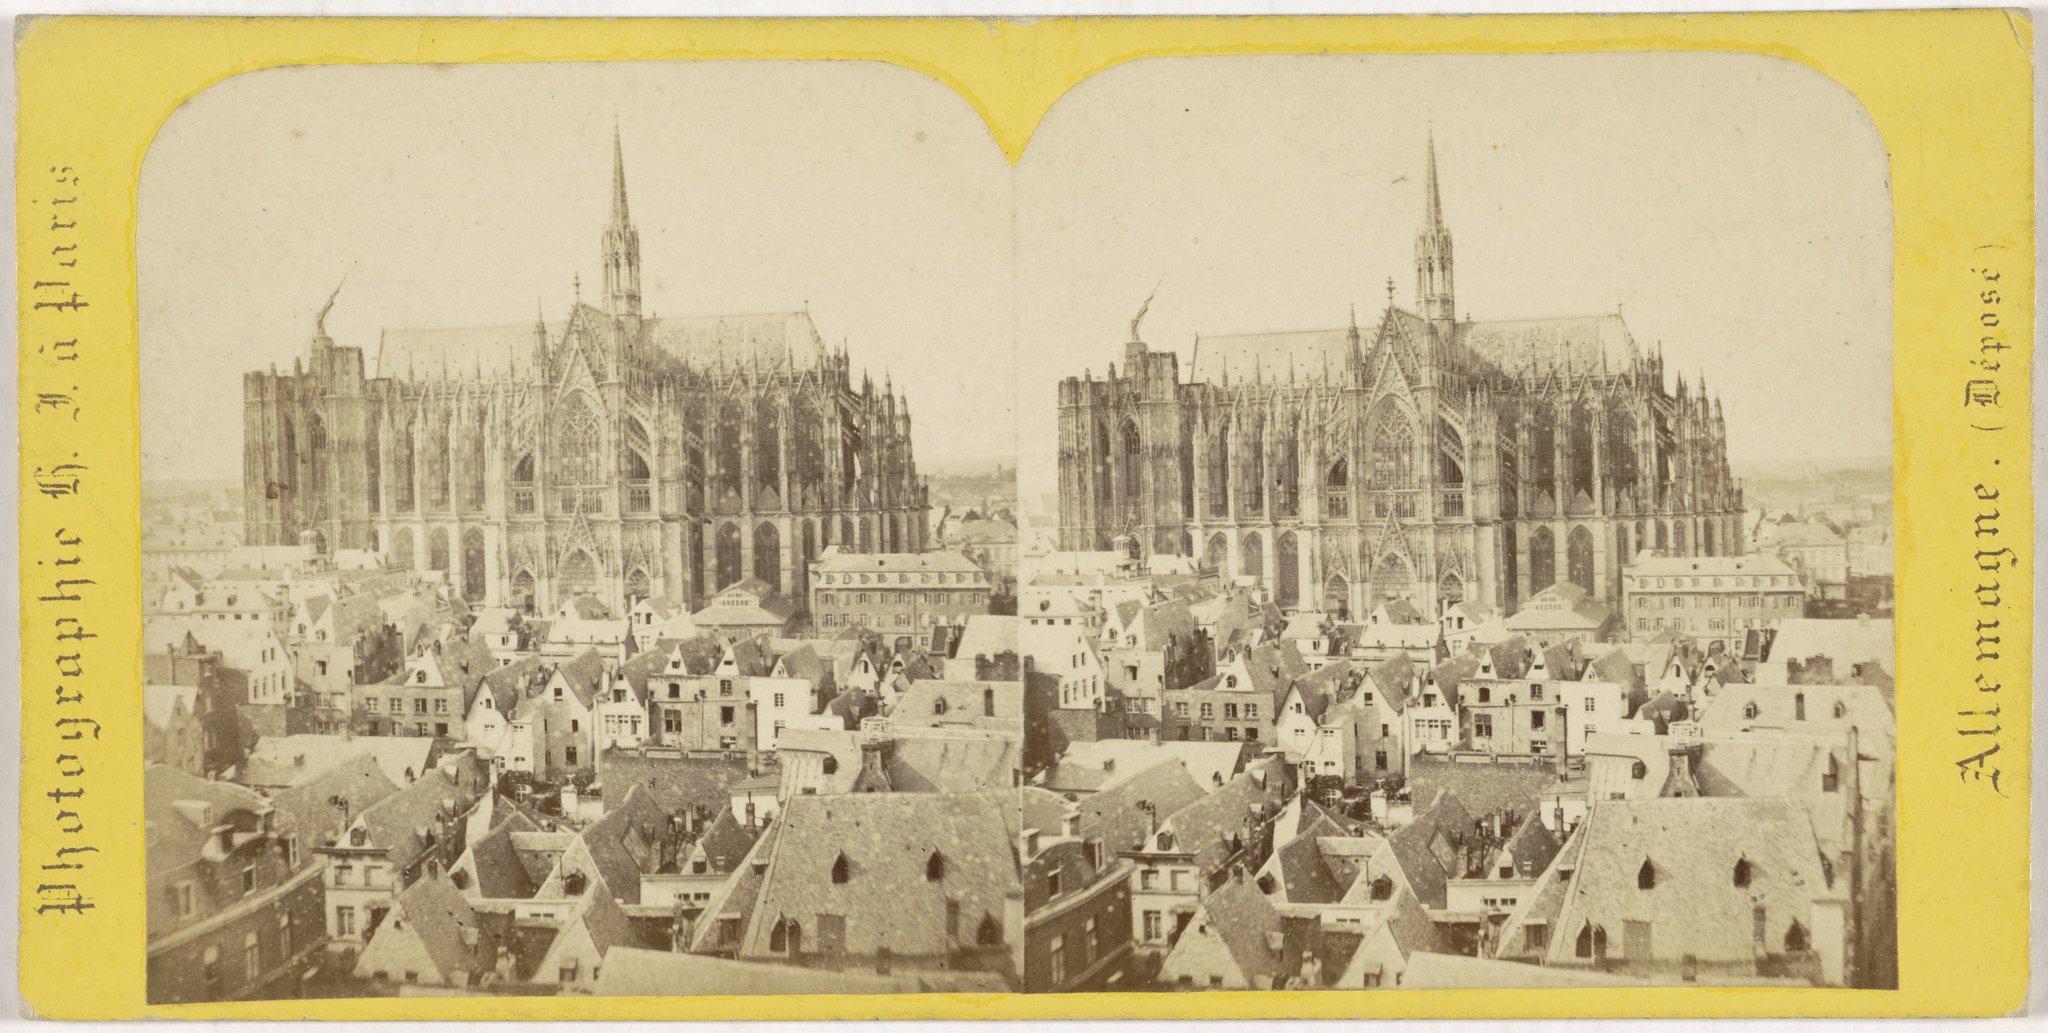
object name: stereograph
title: Vue generale de la Cathédrale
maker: hippolyte jouvin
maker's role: fotograaf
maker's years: 1825-1889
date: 1864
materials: cardboard, paper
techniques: albumen print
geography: cologne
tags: city-view in general; 'veduta', church (exterior)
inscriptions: inscription: ‘(Déposé)’, number: ‘N. 550’, inscription: ‘[...]’, inscription: ‘Déposé.’